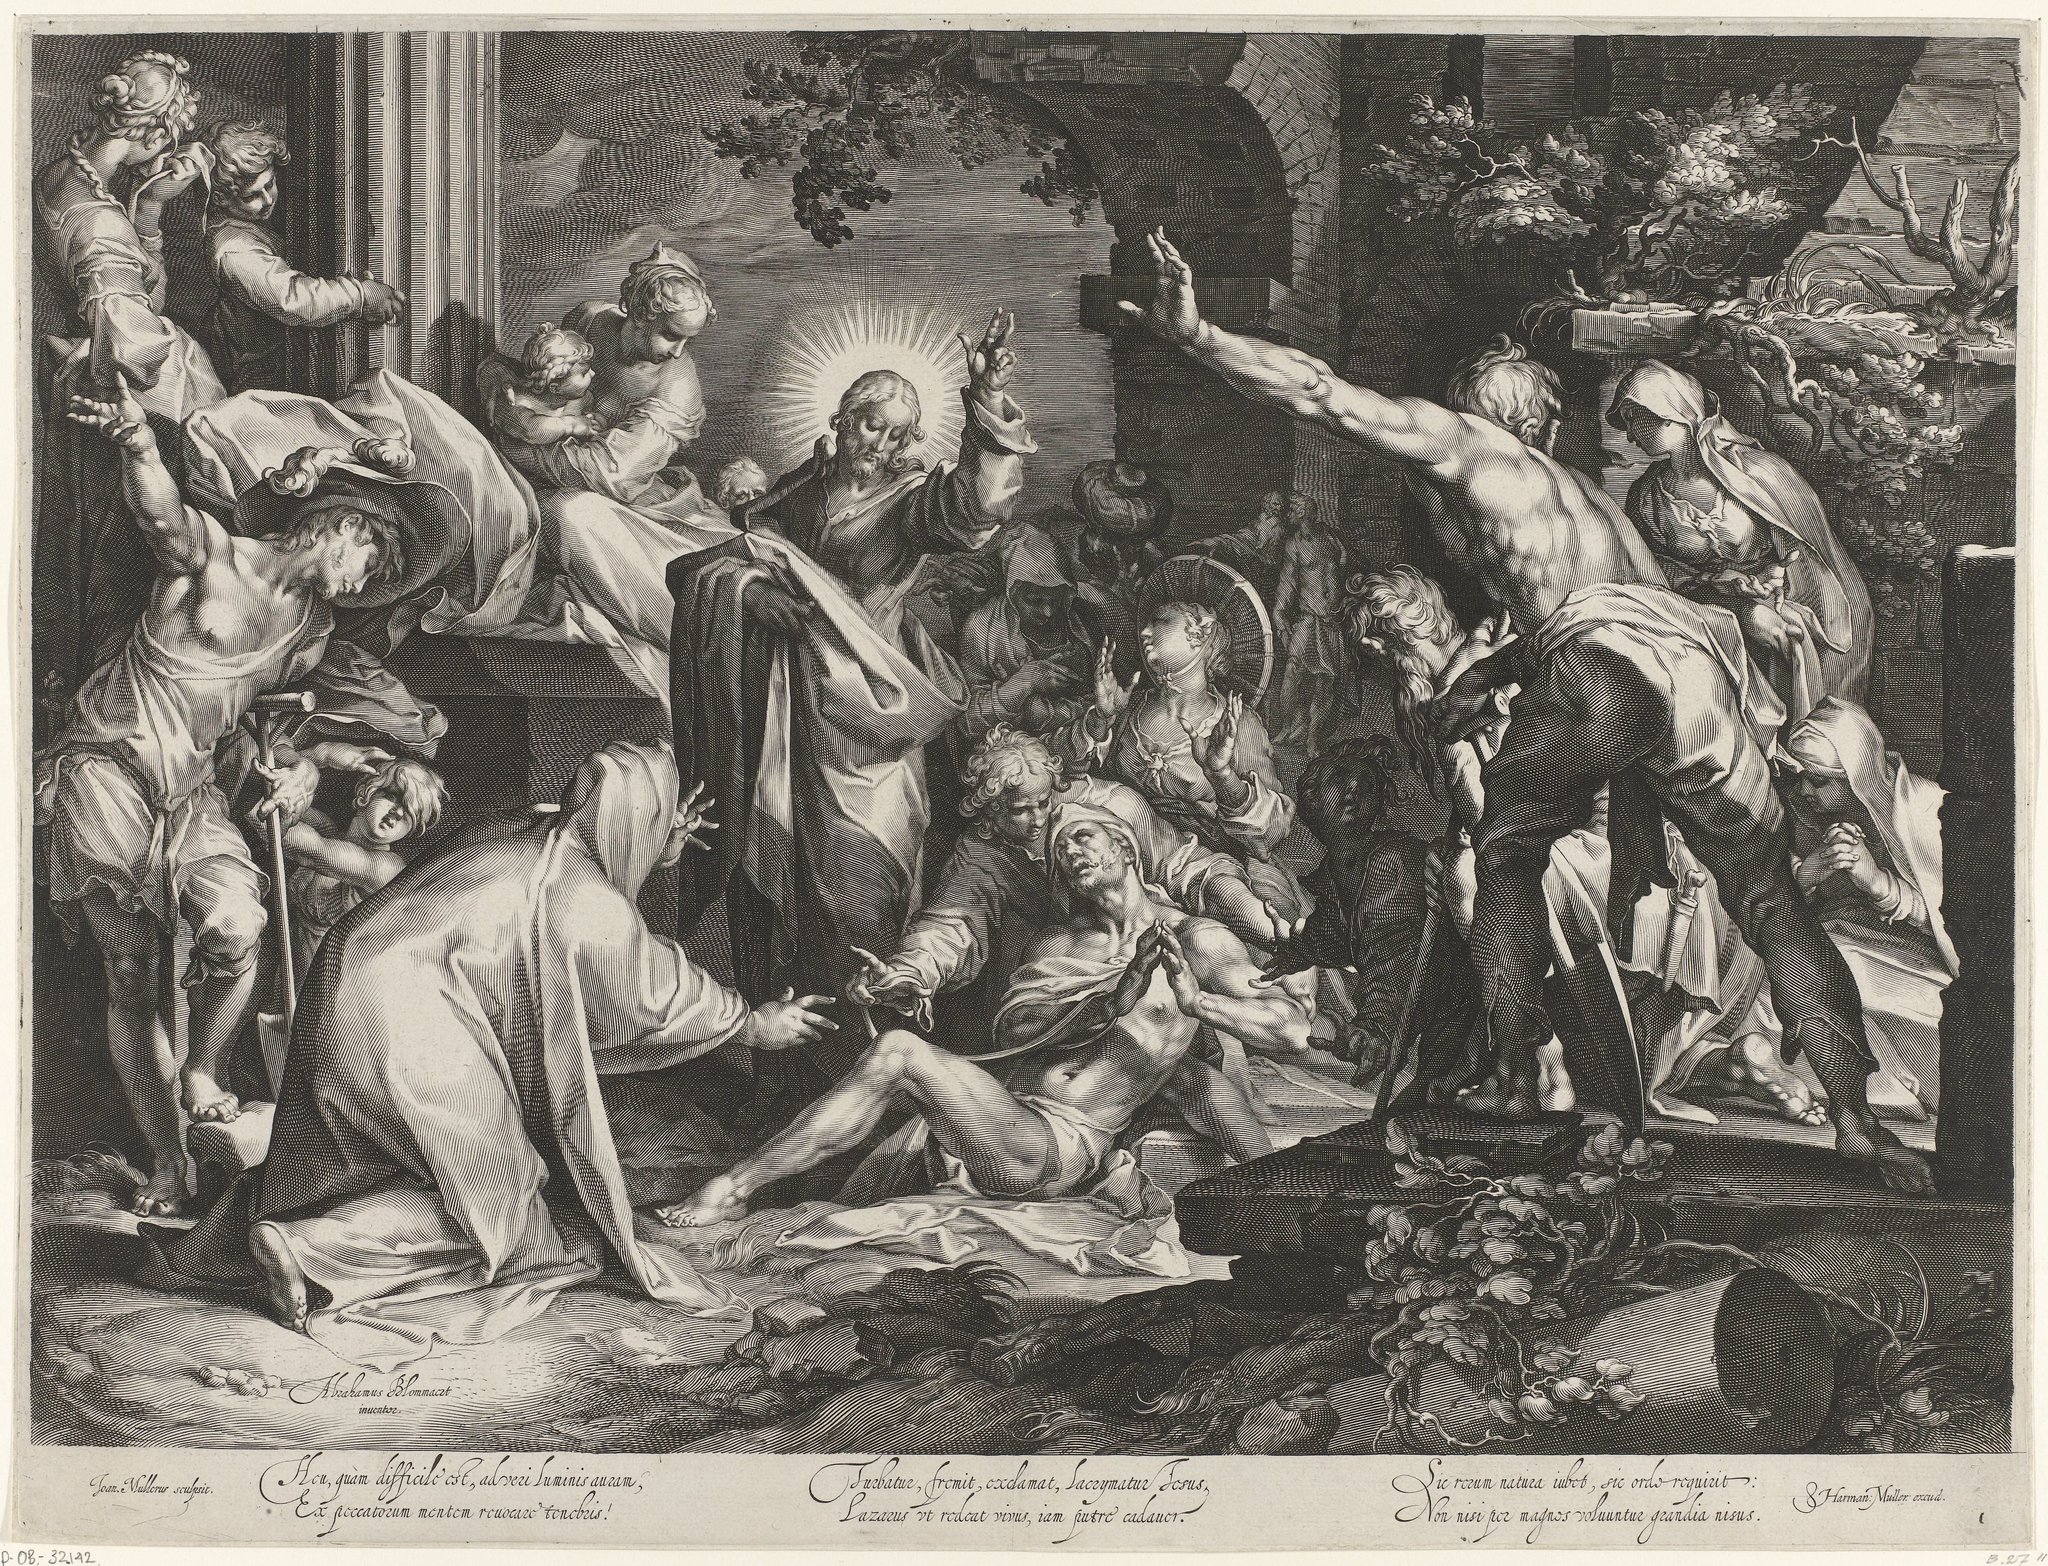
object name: print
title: Opwekking van Lazarus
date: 1598-1602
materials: paper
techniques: engraving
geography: amsterdam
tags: the raising of lazarus ('lazarus, come out')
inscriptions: collector's mark: Lugt 240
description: Christus wekt Lazarus op uit de dood. Lazarus vouwt zijn handen samen. De omstanders reageren verbaasd en verwonderd.